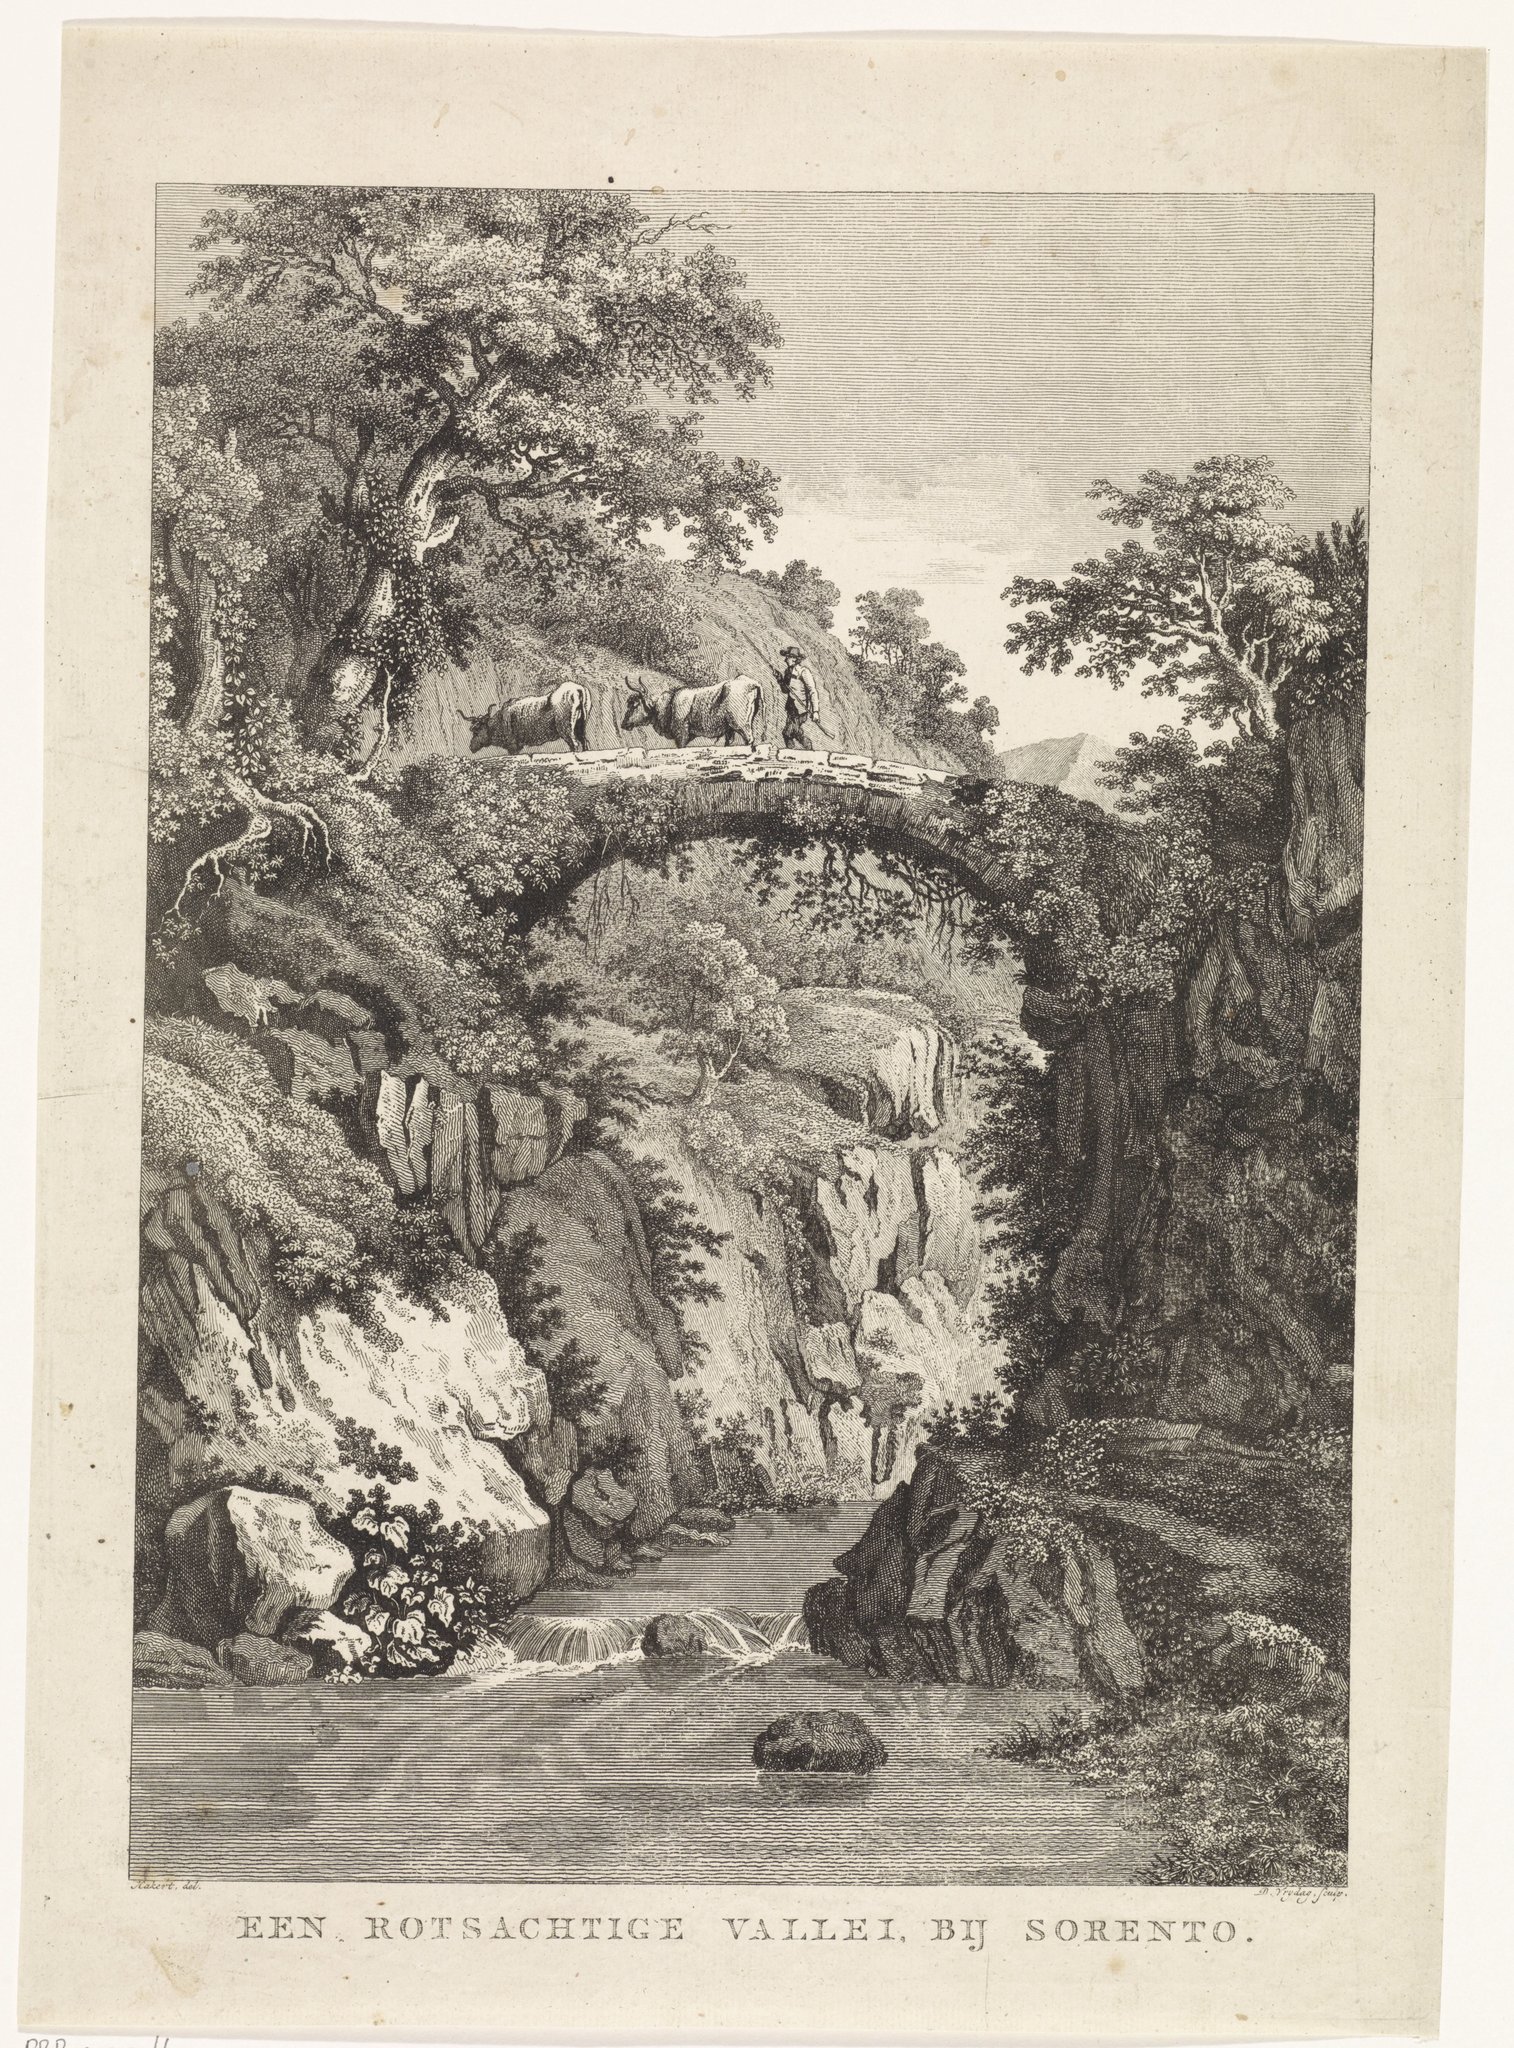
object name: print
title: Gezicht op een bergachtig landschap nabij Sorrento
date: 1800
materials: paper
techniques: etching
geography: amsterdam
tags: cow, landscape with bridge, viaduct or aqueduct - ii - ideal landscapes, sorrento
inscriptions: collector's mark: Lugt 2228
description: Deze prent is gebruikt als illustratie in: Stolberg, graaf Friedrich Leopold zu. Reis door Duitschland, Zwitserland, Italie en Sicilie, deel III, p. 180. Amsterdam: Johannes Allart, 1800.